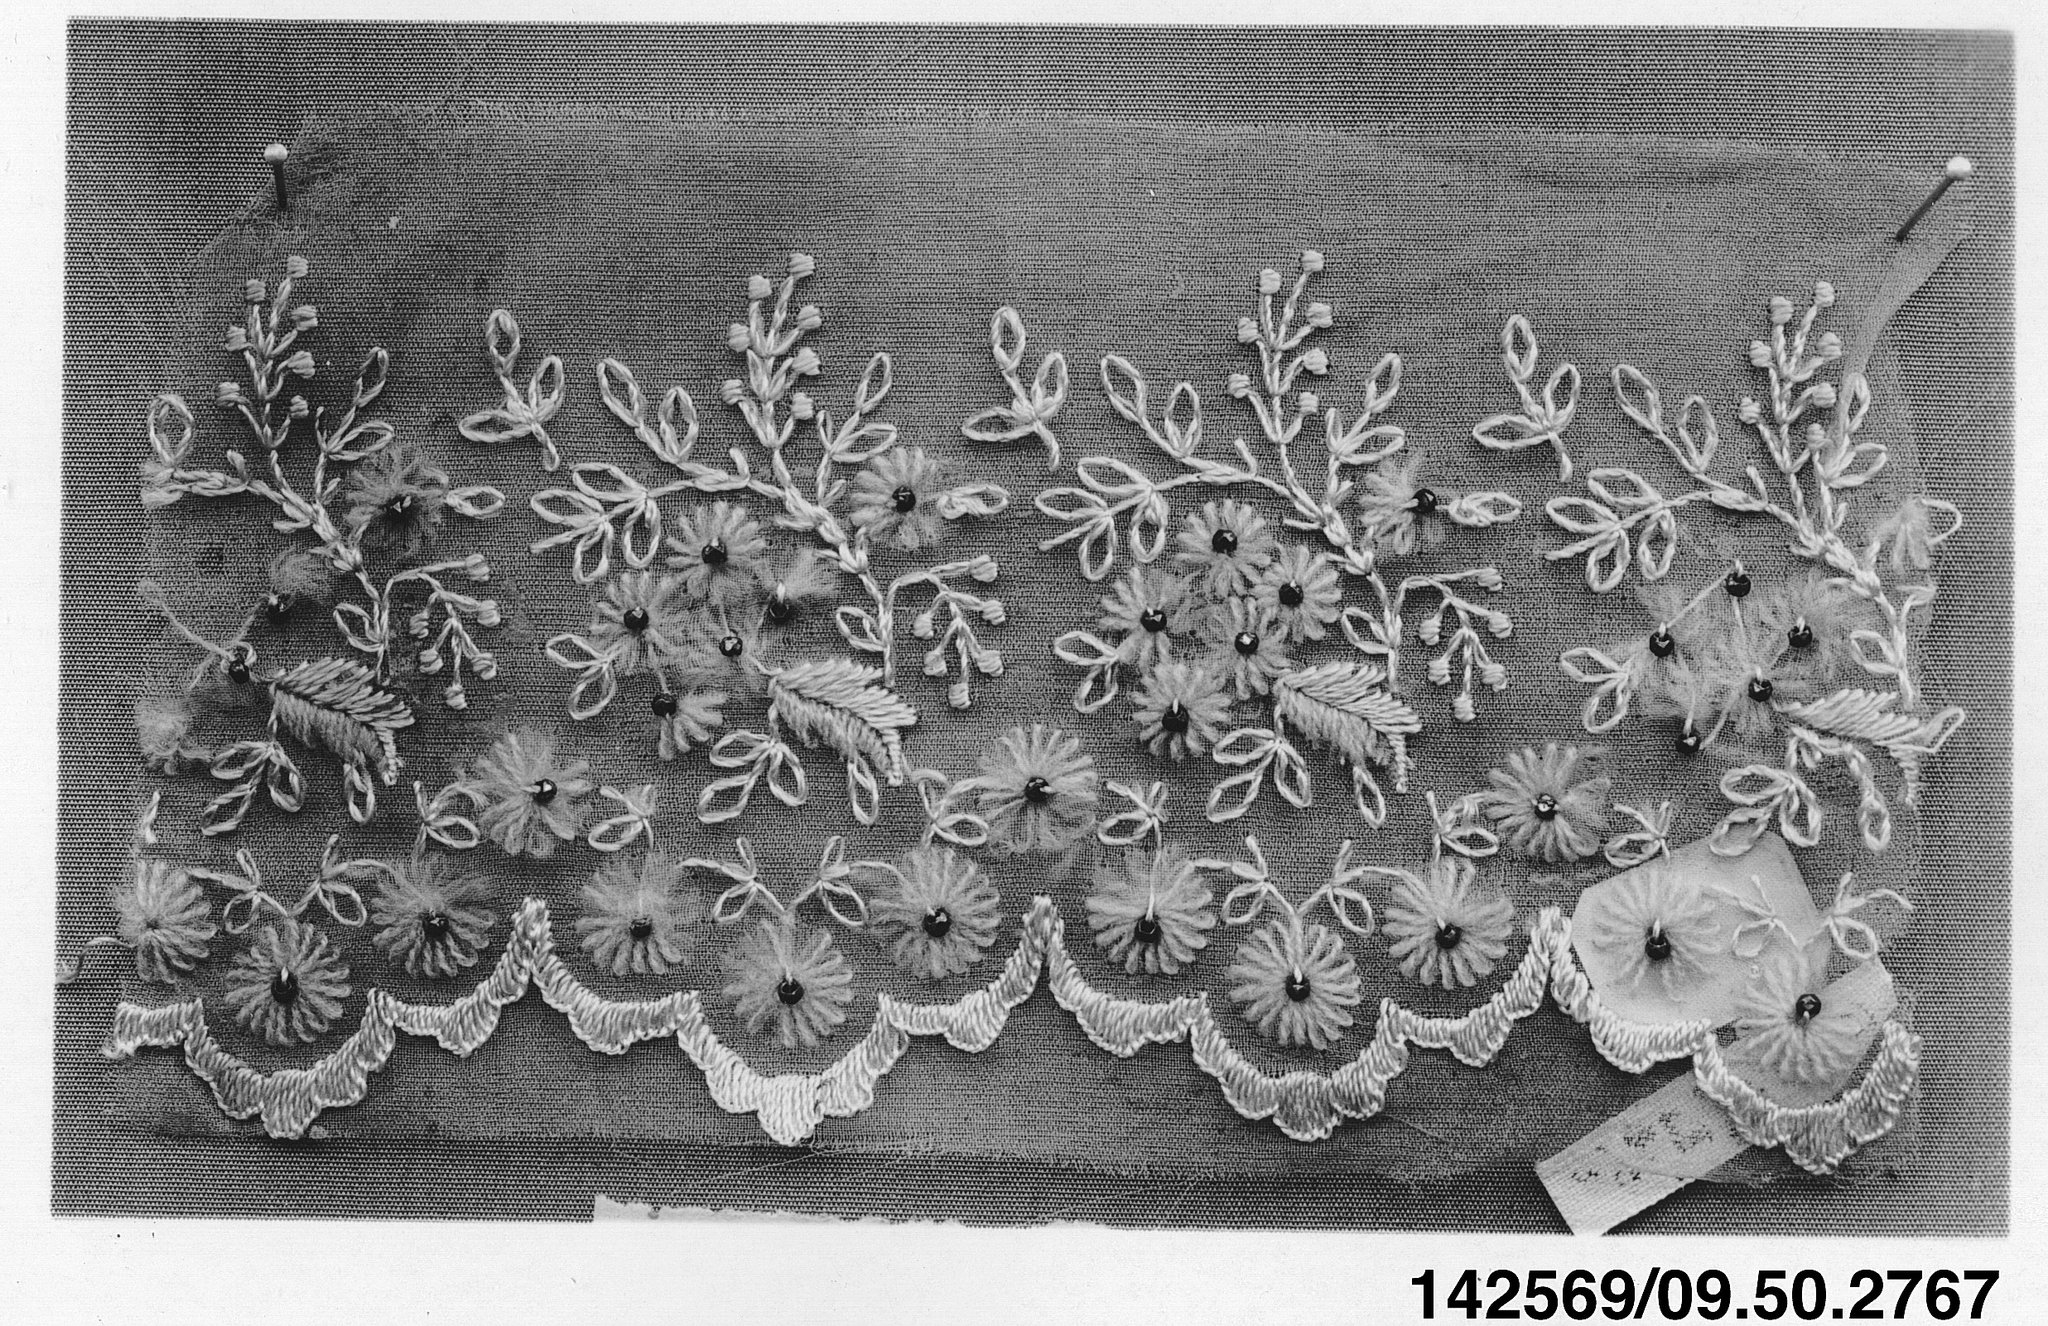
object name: border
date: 1801-1900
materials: silk, wool